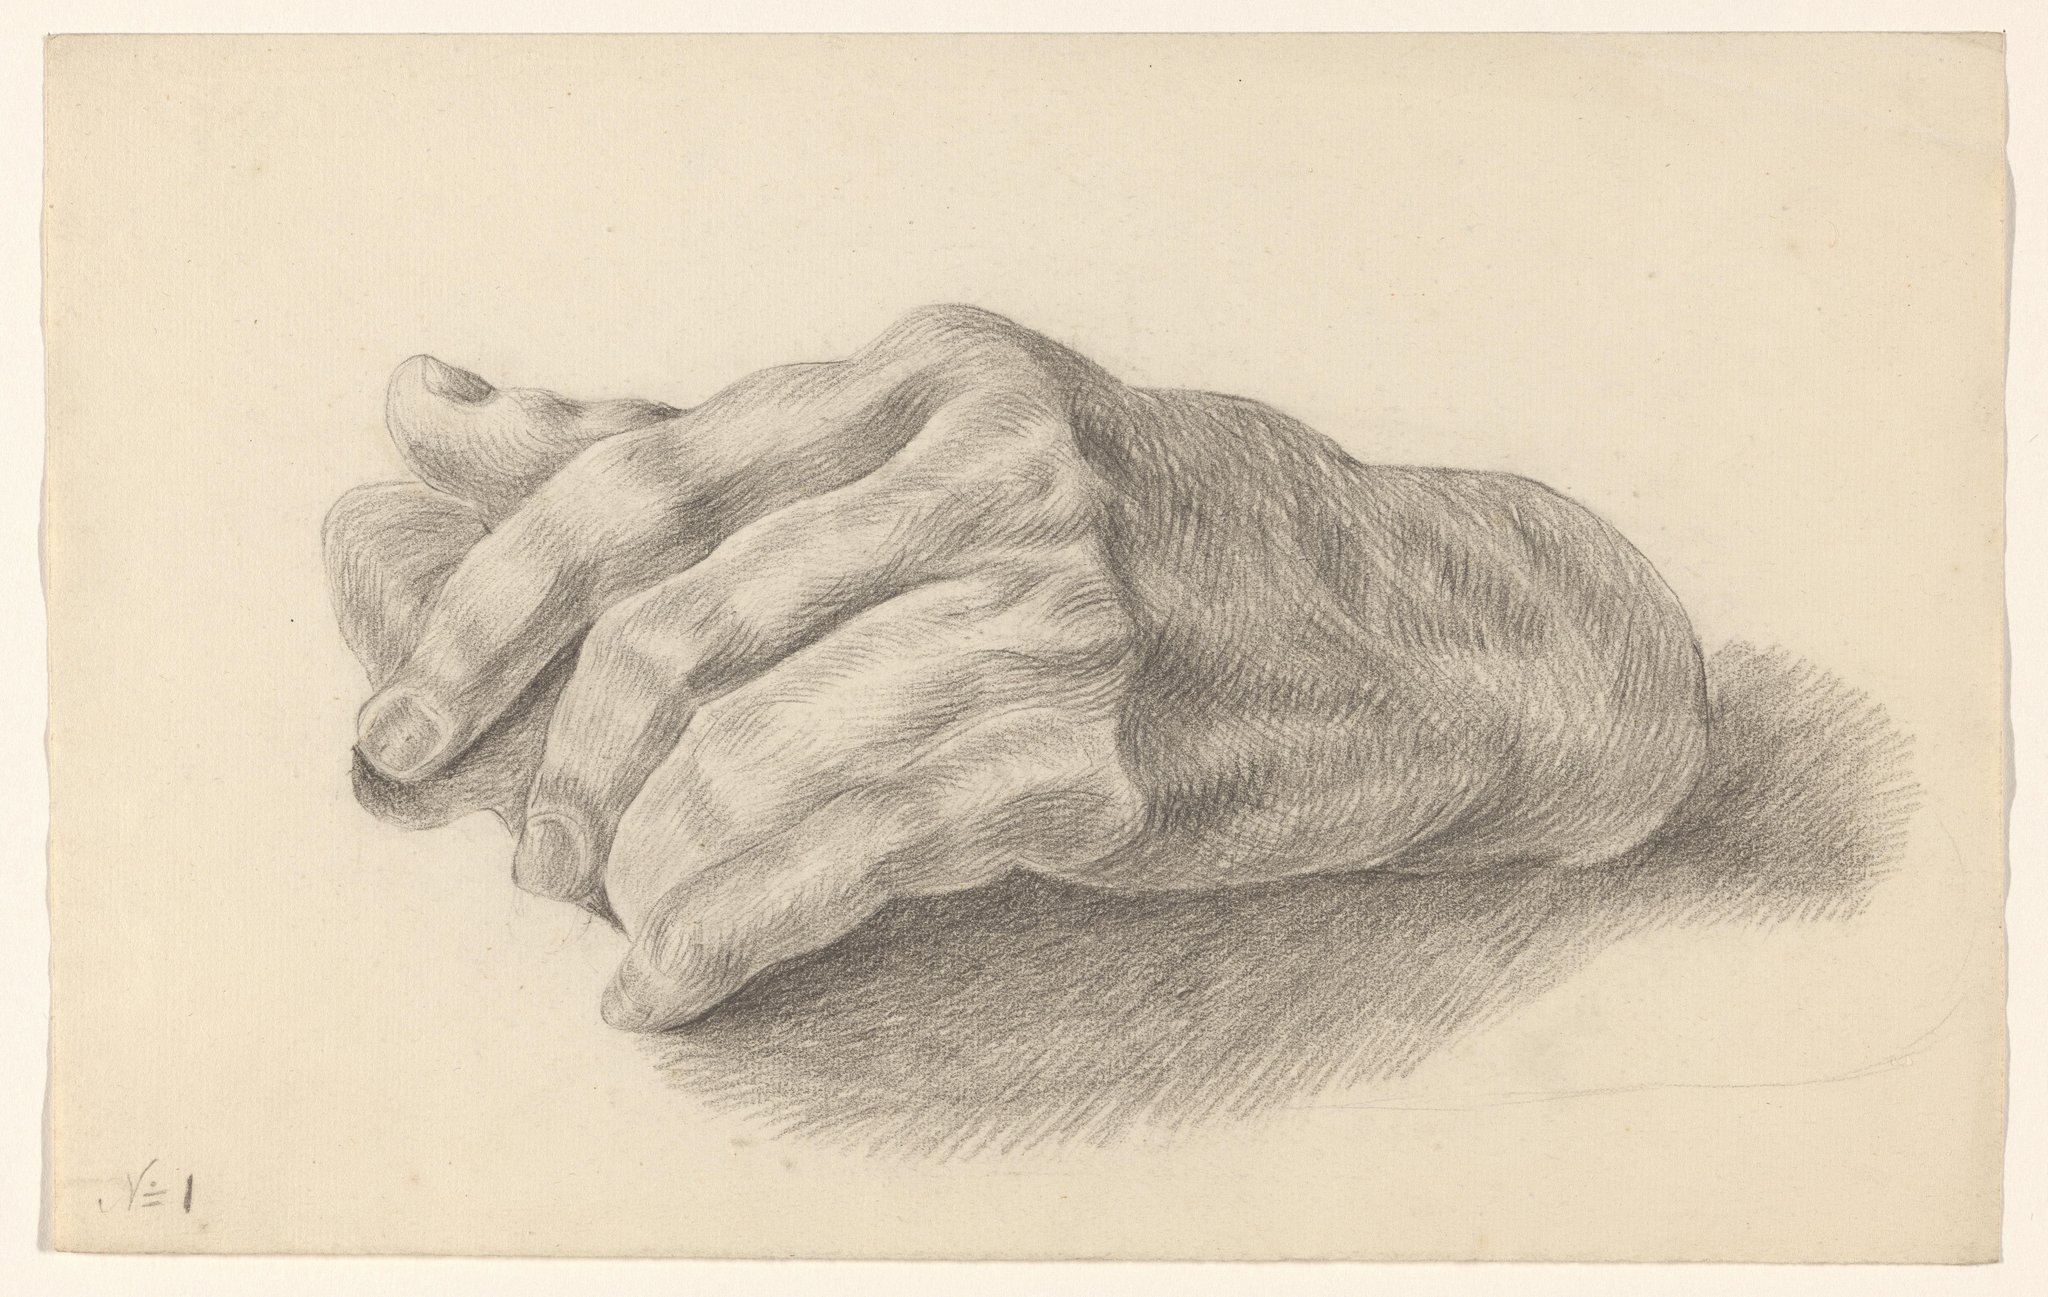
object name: drawing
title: Studie van een hand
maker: joannes carolus alberdingk thijm (jan)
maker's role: pater, schrijver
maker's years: 1847-1926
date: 1855-1870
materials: chalk, paper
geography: netherlands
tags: hand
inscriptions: inscription: ‘No 1’